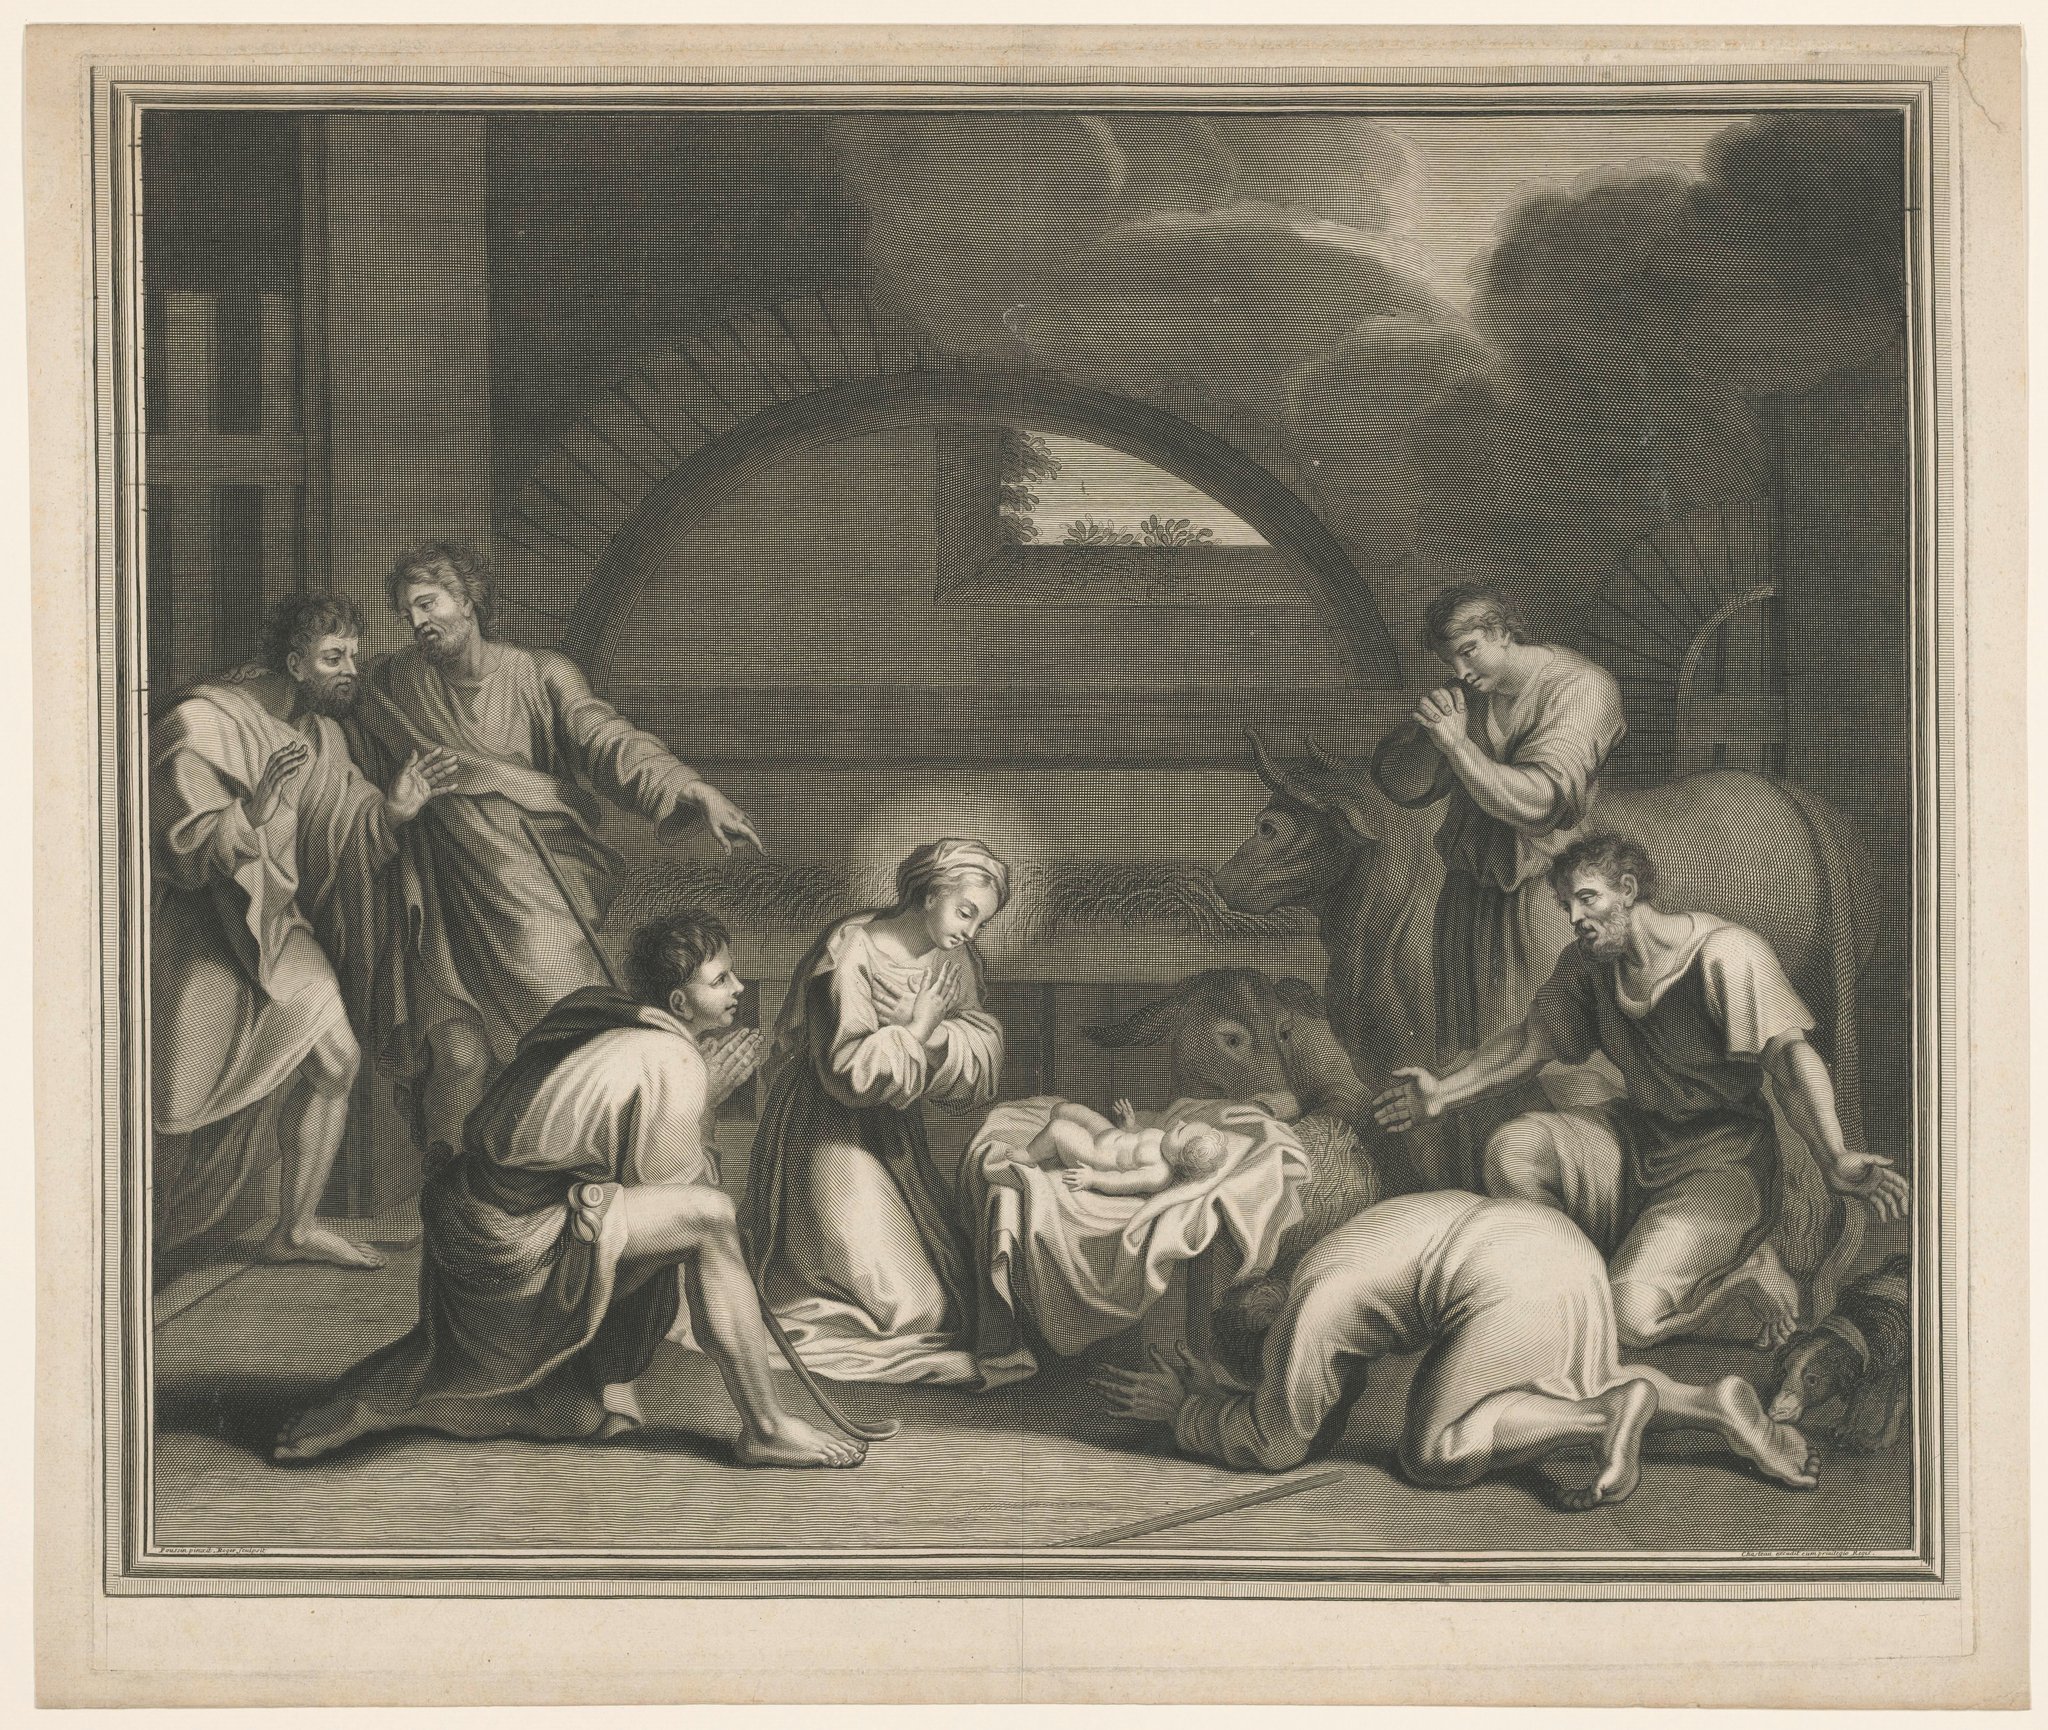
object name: print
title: Aanbidding door de herders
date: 1777-1841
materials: paper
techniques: engraving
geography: france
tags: adoration of the christ-child by the shepherds; mary and joseph present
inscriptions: collector's mark: Lugt 240